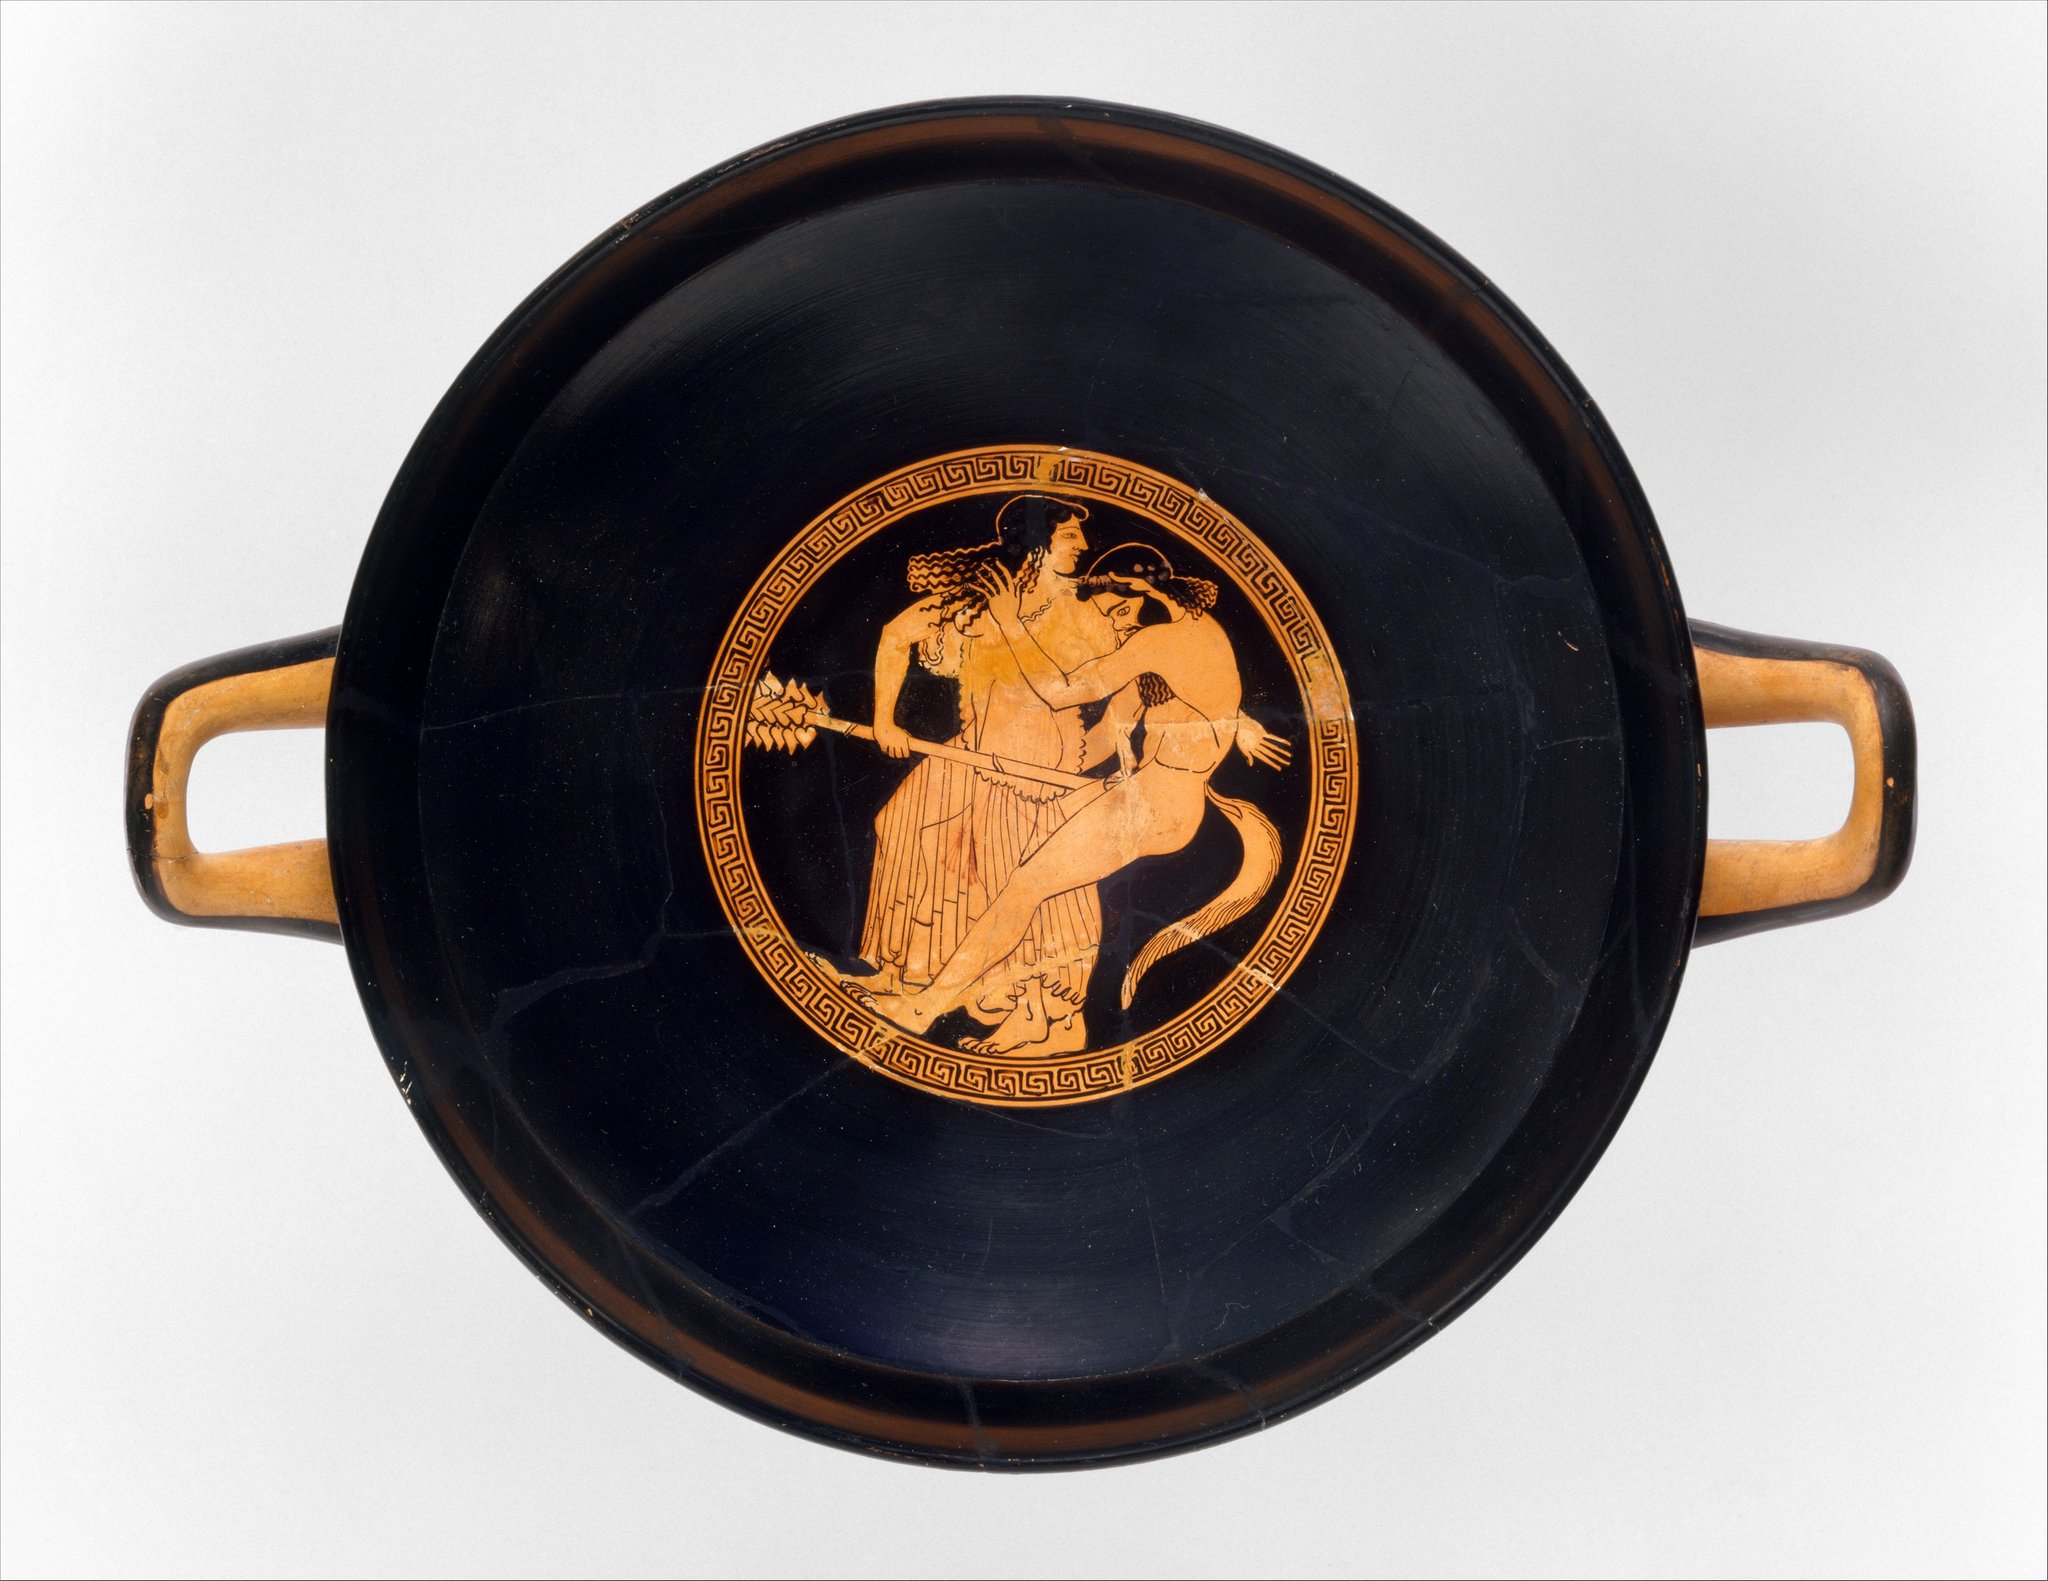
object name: kylix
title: Terracotta kylix (drinking cup)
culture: greek, attic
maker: makron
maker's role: artist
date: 490-480 BCE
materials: terracotta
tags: maenads,satyrs